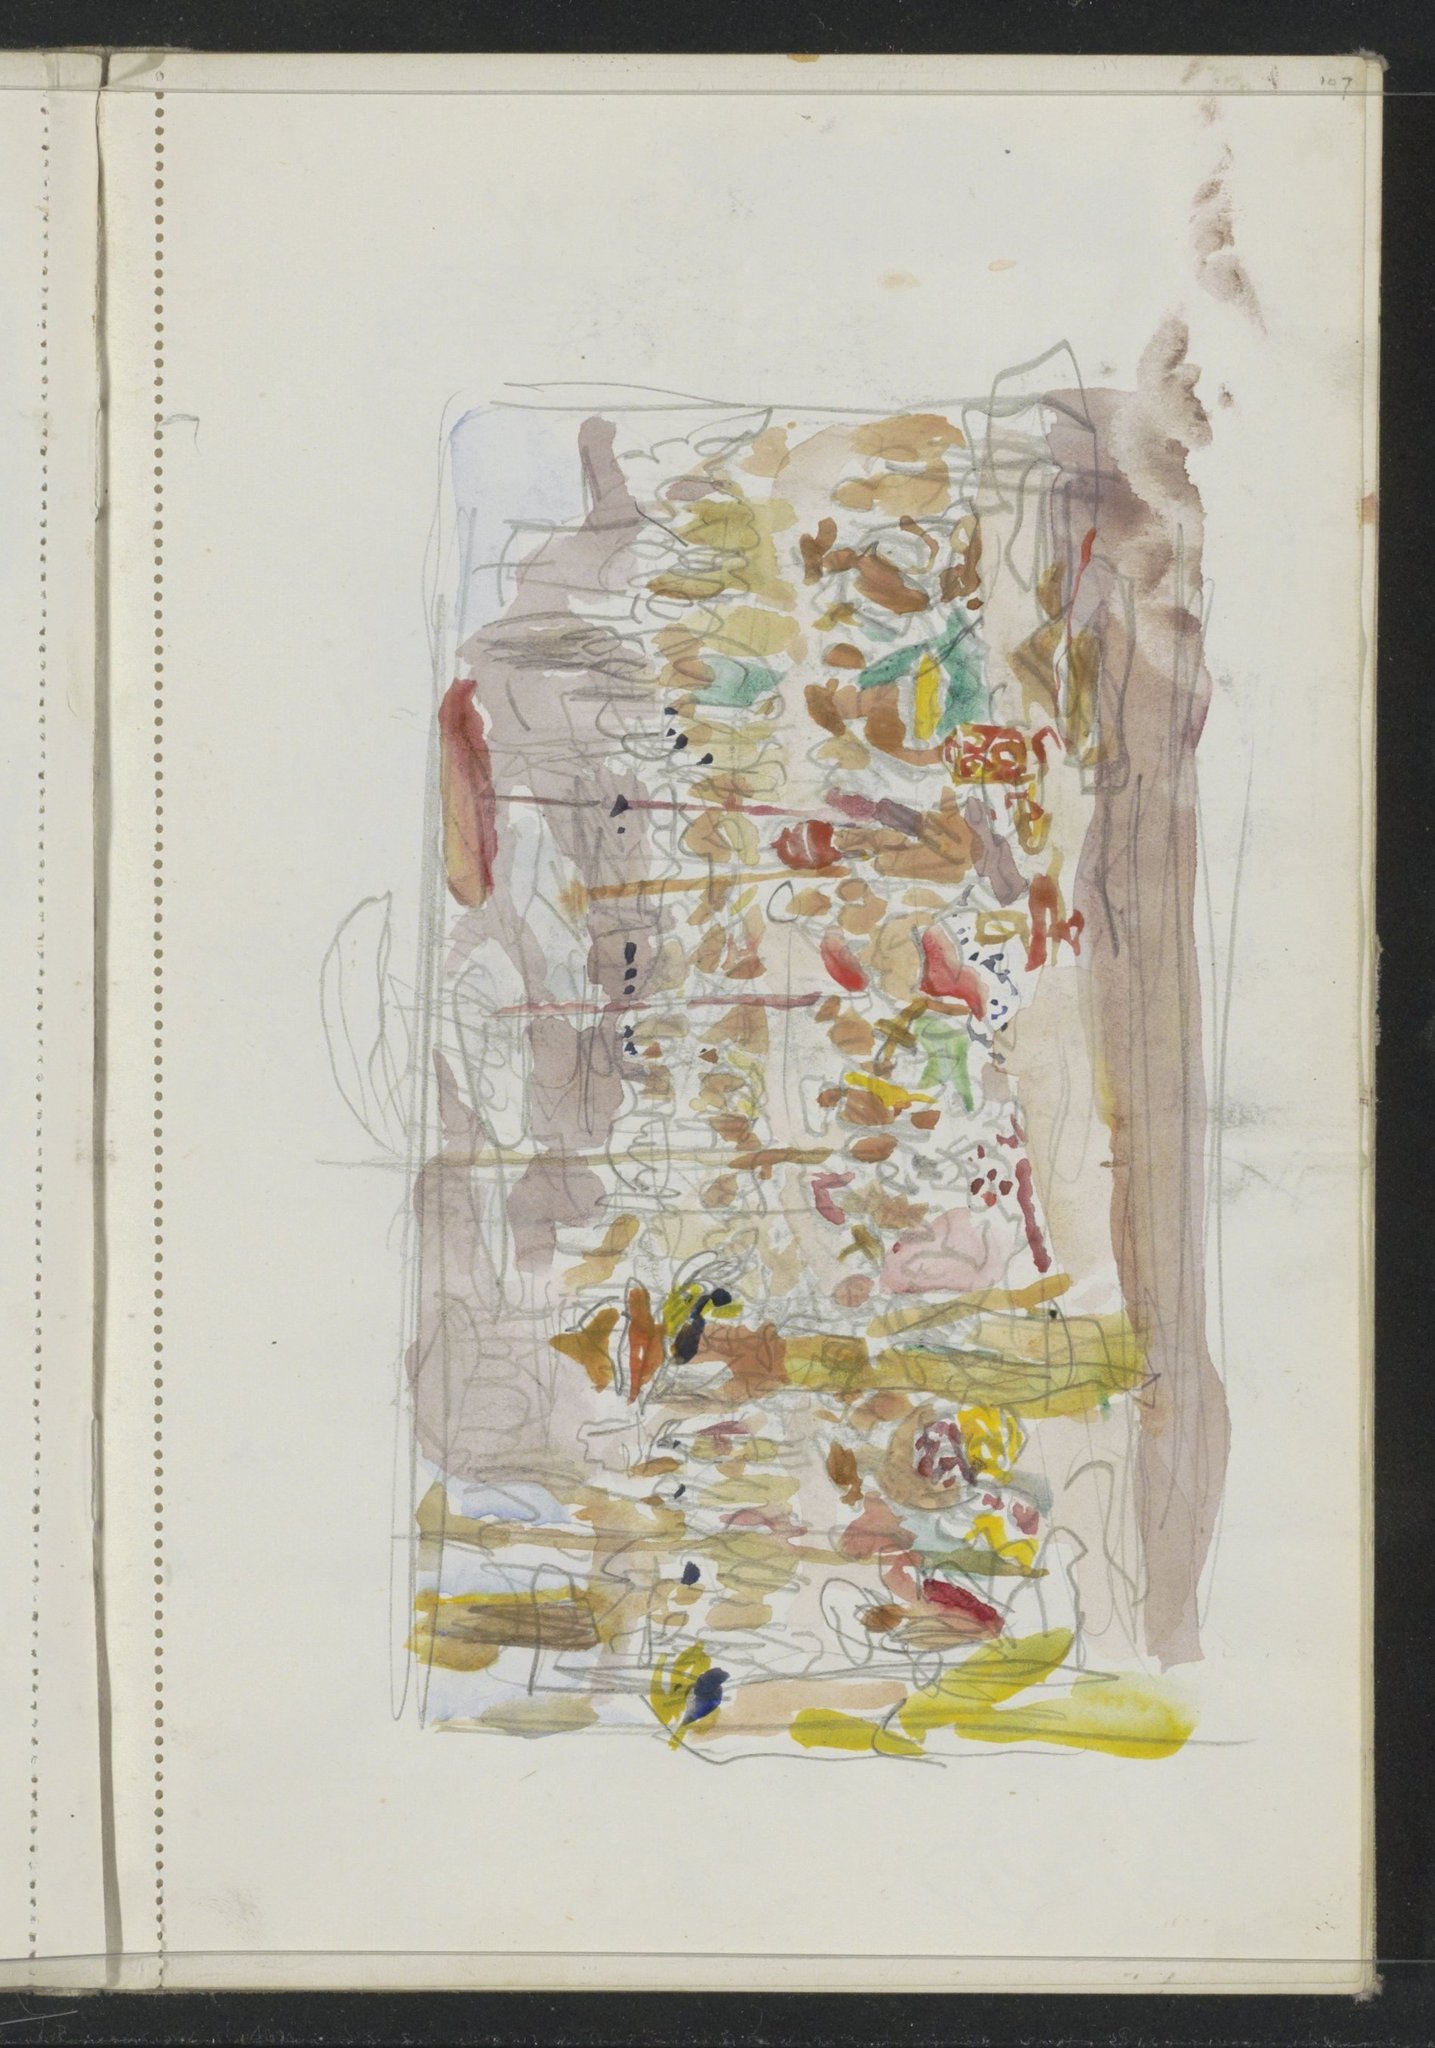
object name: sketchbook leaf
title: Plein met zittende Indonesiërs met parasols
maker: marius bauer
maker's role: draughtsman, print maker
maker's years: 1867-1932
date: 1925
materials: paper, pencil, watercolor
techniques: brush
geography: indonesia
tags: asiatic races and peoples, sitting figure, parasol, sunshade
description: Pagina 107 uit een schetsboek met 74 bladen.